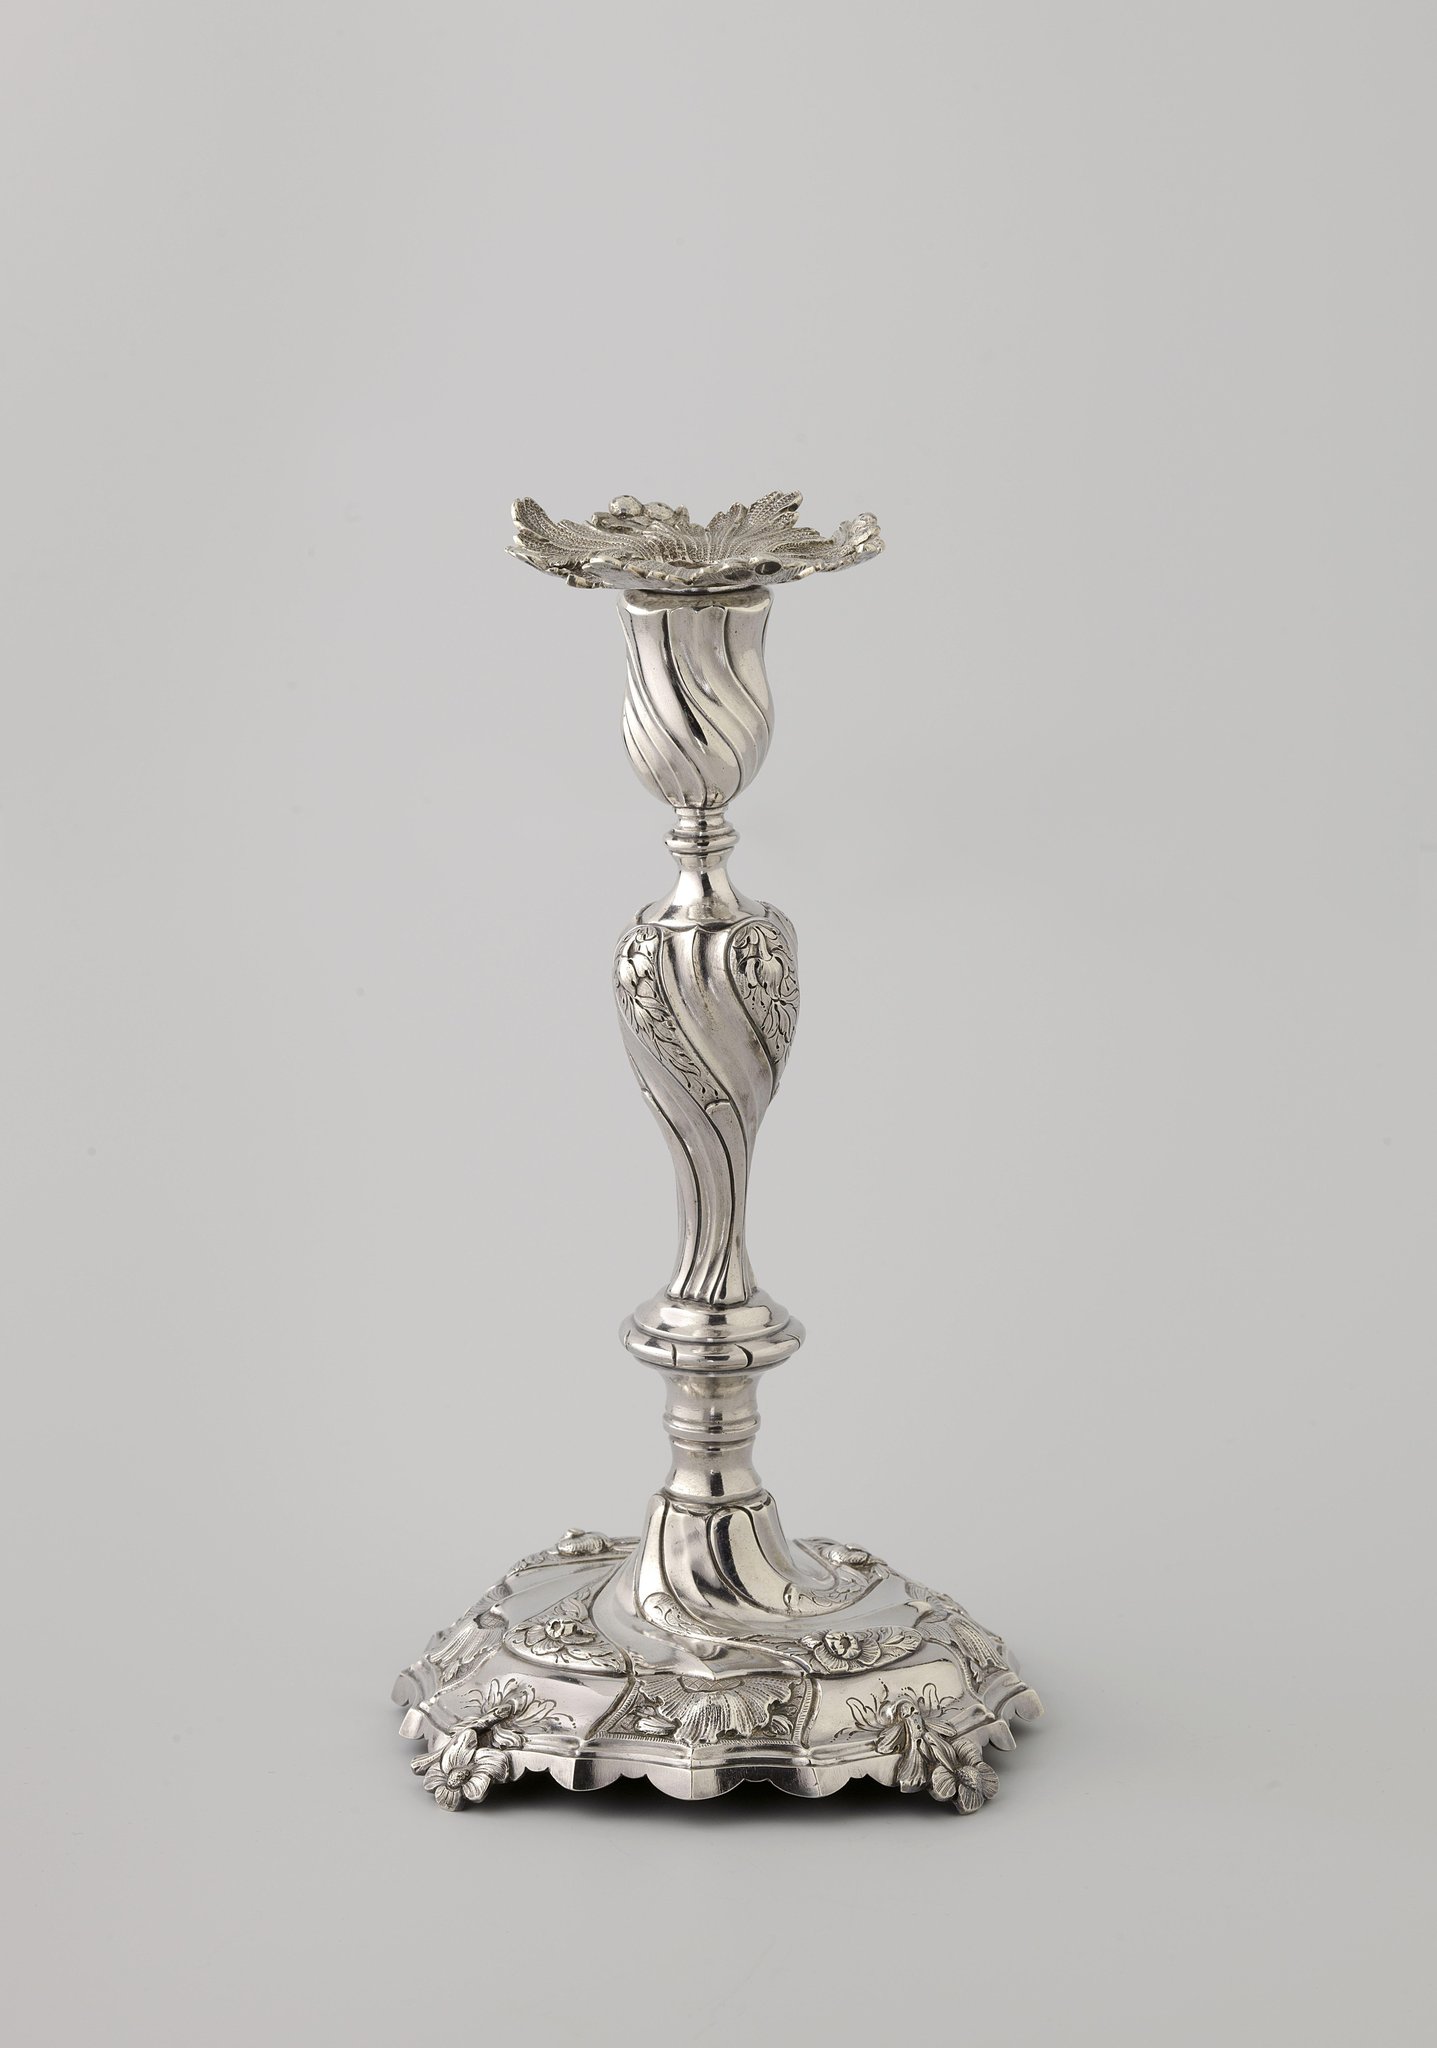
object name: candlestick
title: Kandelaar met langs de getordeerde balusterstam bladslingers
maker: wijnand warneke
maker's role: silversmith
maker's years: 1738-1810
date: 1780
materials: silver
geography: amsterdam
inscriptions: maker's mark, alloy mark, duty mark, assay office mark, date letter: ‘V’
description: De gewelfde, getrapte voet, de balustervormige stam en de kaarsenhouder zijn alle getorst en zijn opgebouwd uit afwisselend lobben en geribde gedeeltes. De voet heeft een gecontourneerde onderrand. Hij rust op vier bloemtakjes die op de hoeken uit de lobben te voorschijn komen en die als pootjes fungeren. De voet is versierd met gegoten en gegraveerde rocailles en bloemtakken, de stam vertoont op iedere lob een bladertak. Voet, stam, en kaarsenhouder worden van elkaar gescheiden door ronde, geprofileerde gedeeltes. De losse vetvanger is opgebouwd uit opkrullende bladeren met bessen.